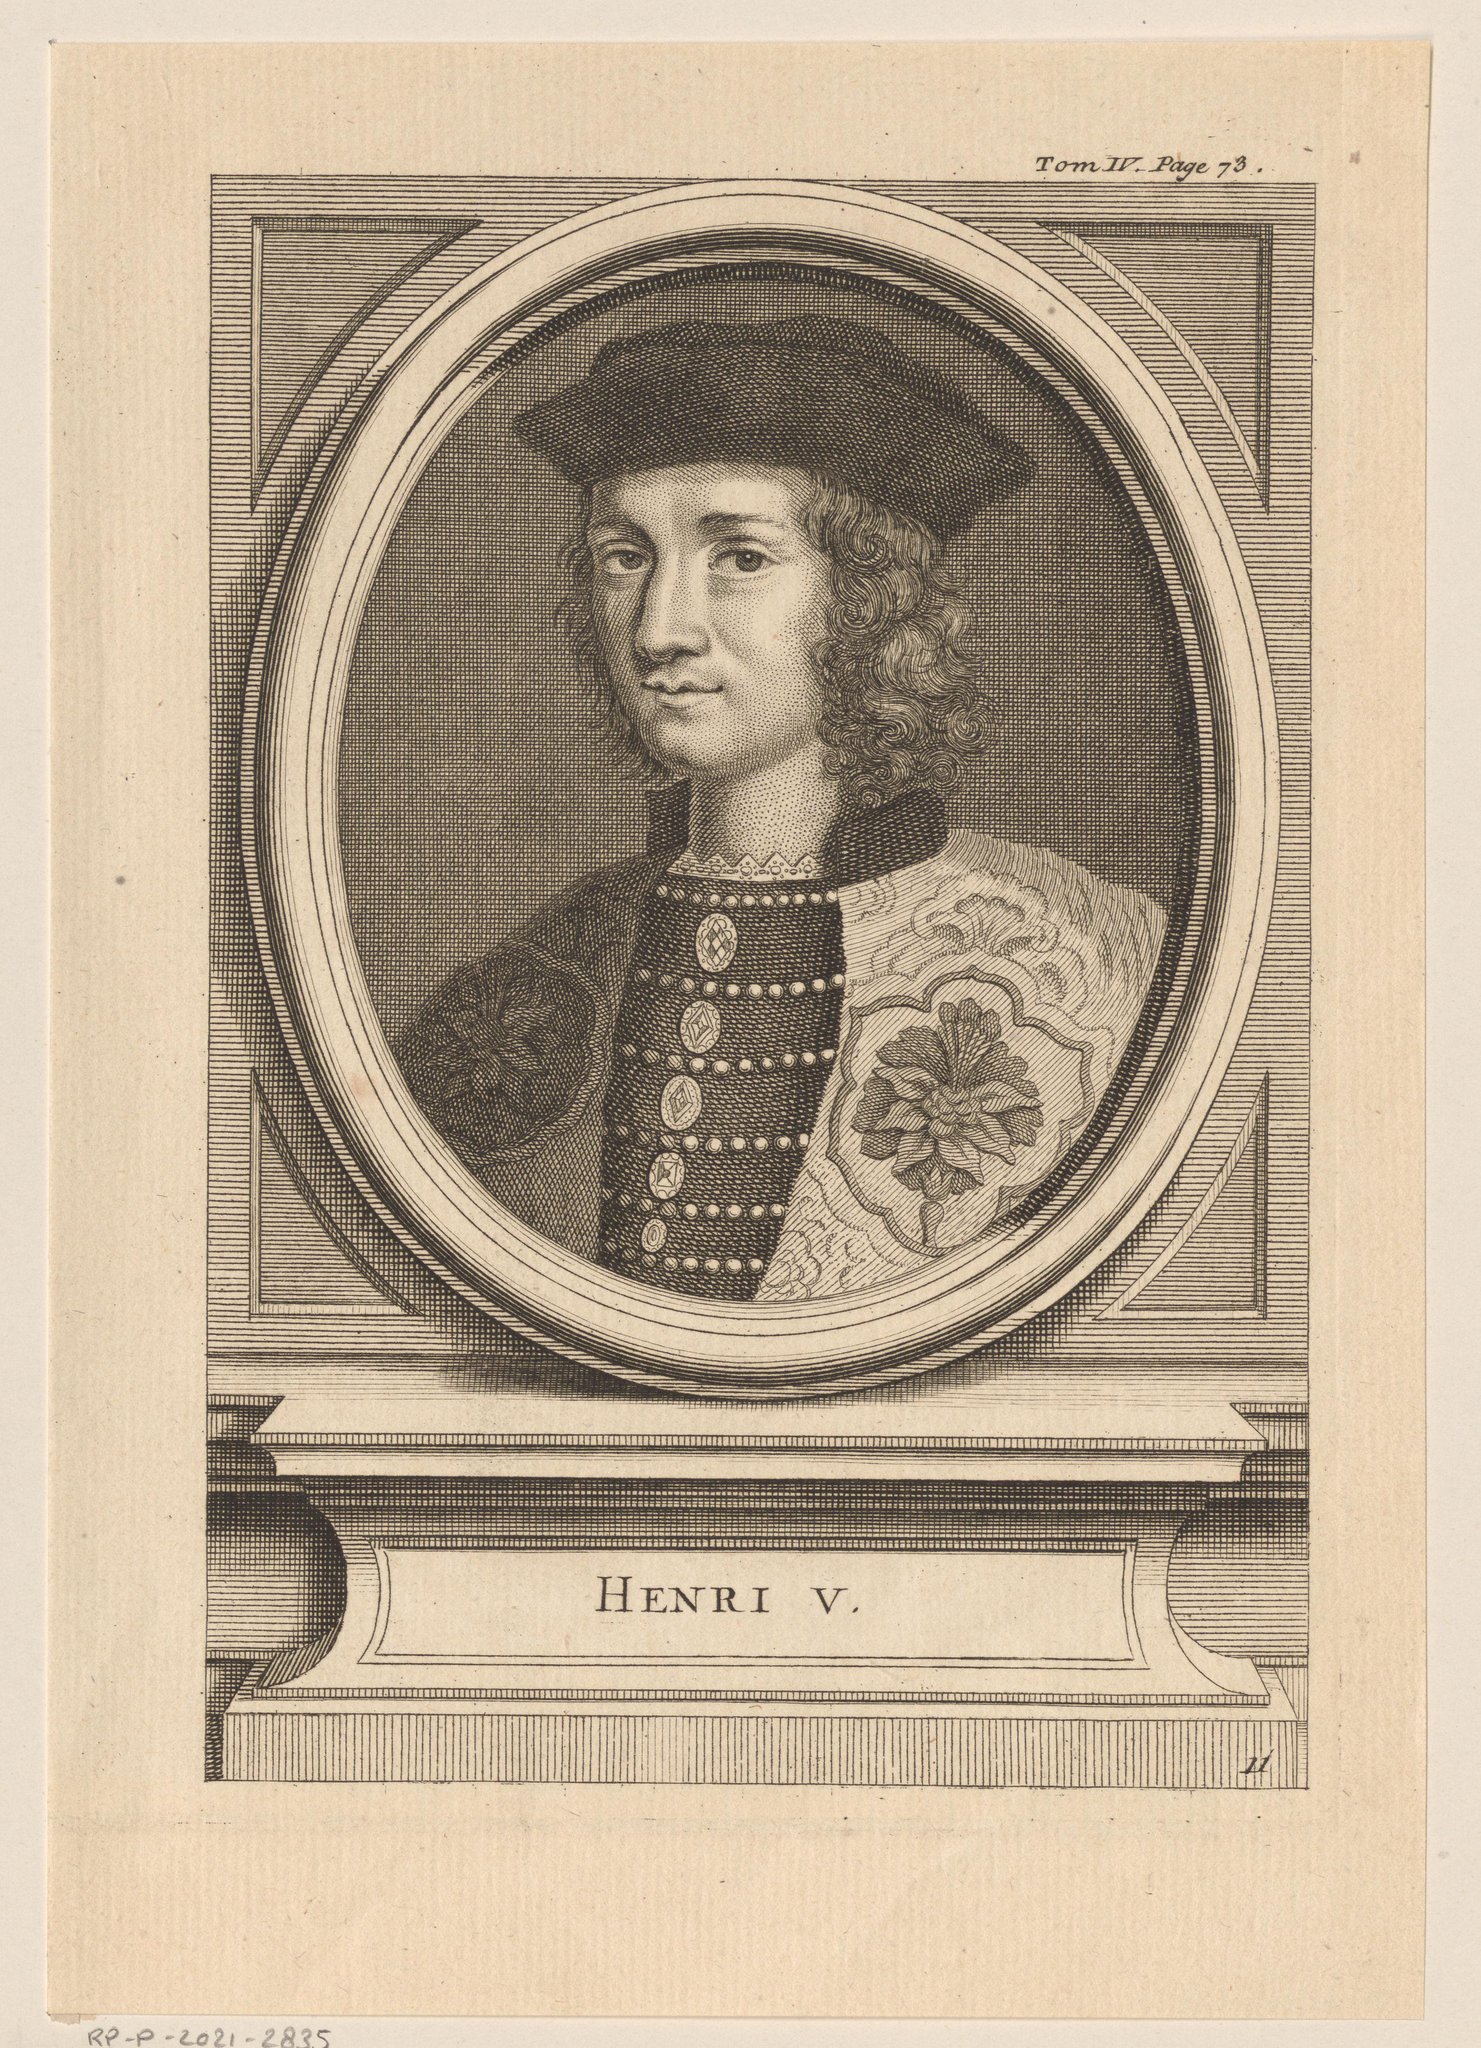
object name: book illustration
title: Portret van Hendrik V, koning van Engeland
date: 1749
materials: paper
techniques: engraving, etching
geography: amsterdam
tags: historical persons, king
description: Prent uit: Rapin Thoyras, Paul de. Histoire d'Angleterre. Den Haag: s.n., 1749, dl. 4. Prent mogelijk ook gebruikt in andere publicaties.